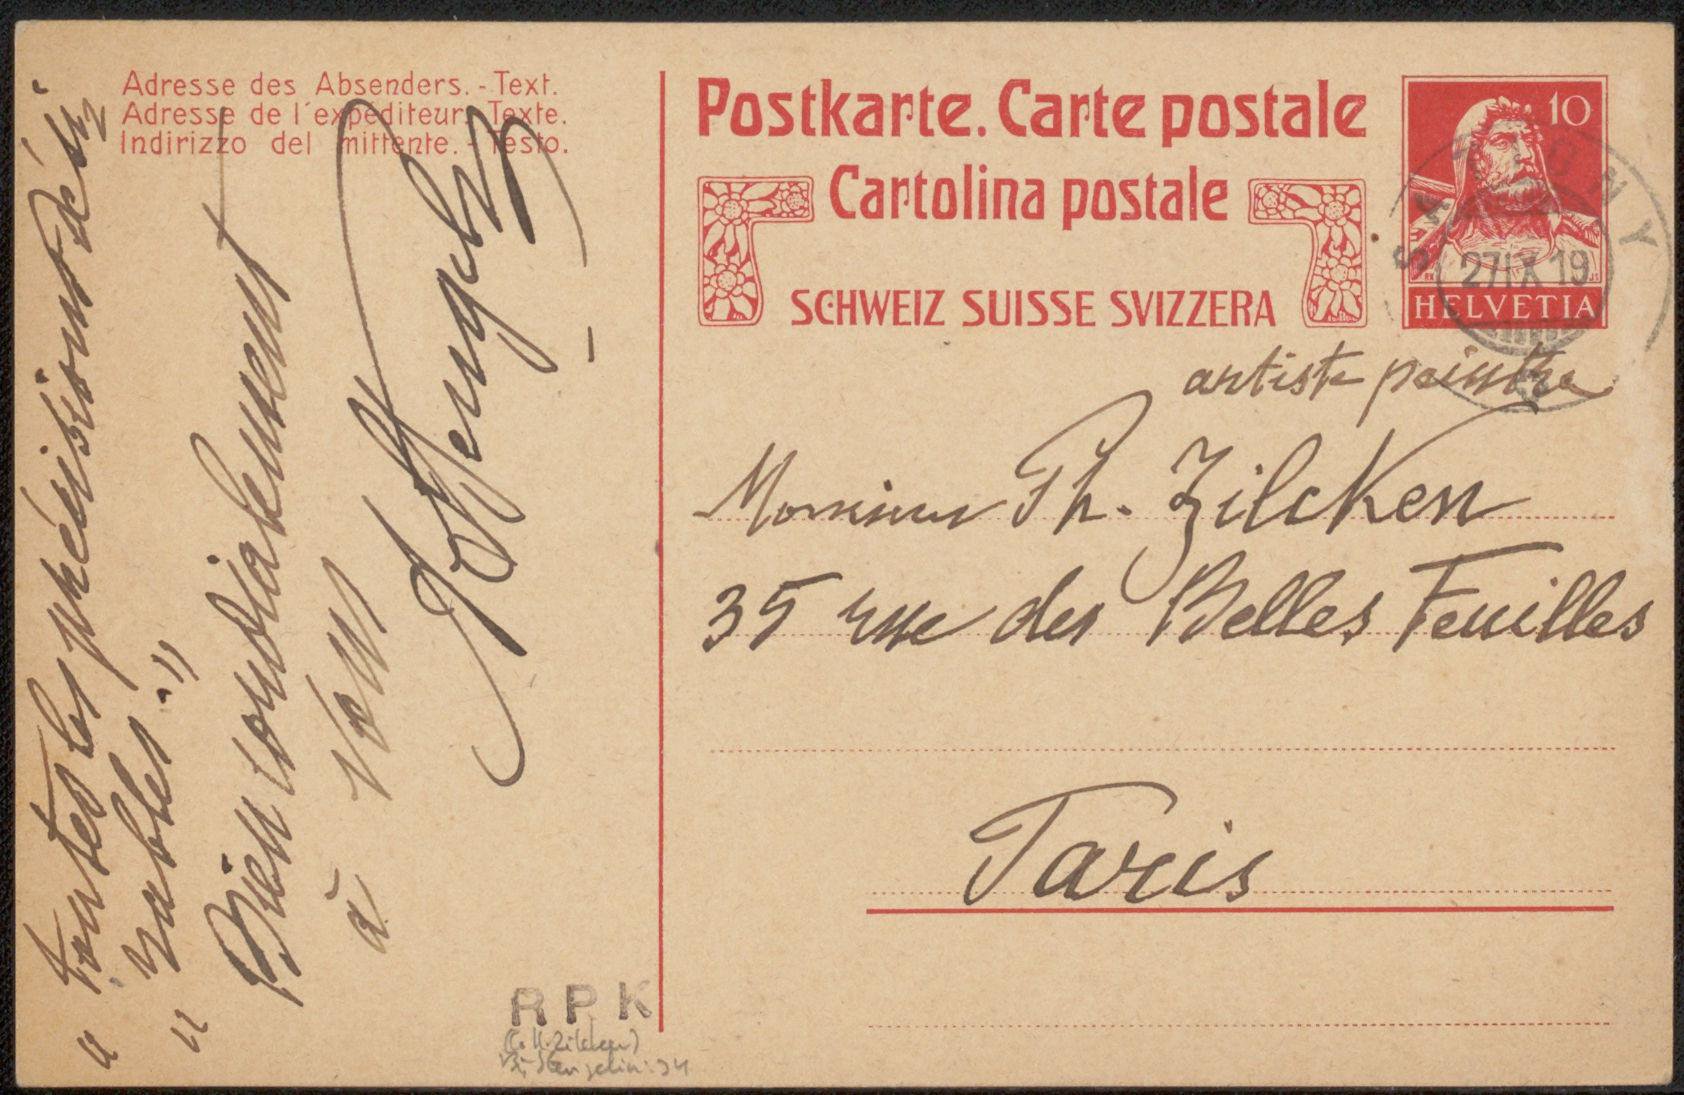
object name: postcard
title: Briefkaart aan Philip Zilcken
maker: alphonse stengelin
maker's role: painter, print maker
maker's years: 1852-1938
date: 1919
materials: cardboard, ink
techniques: pen, writing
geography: satigny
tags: the hague, painter, draughtsman, philip zilcken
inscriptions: collector's mark: ‘RPK’